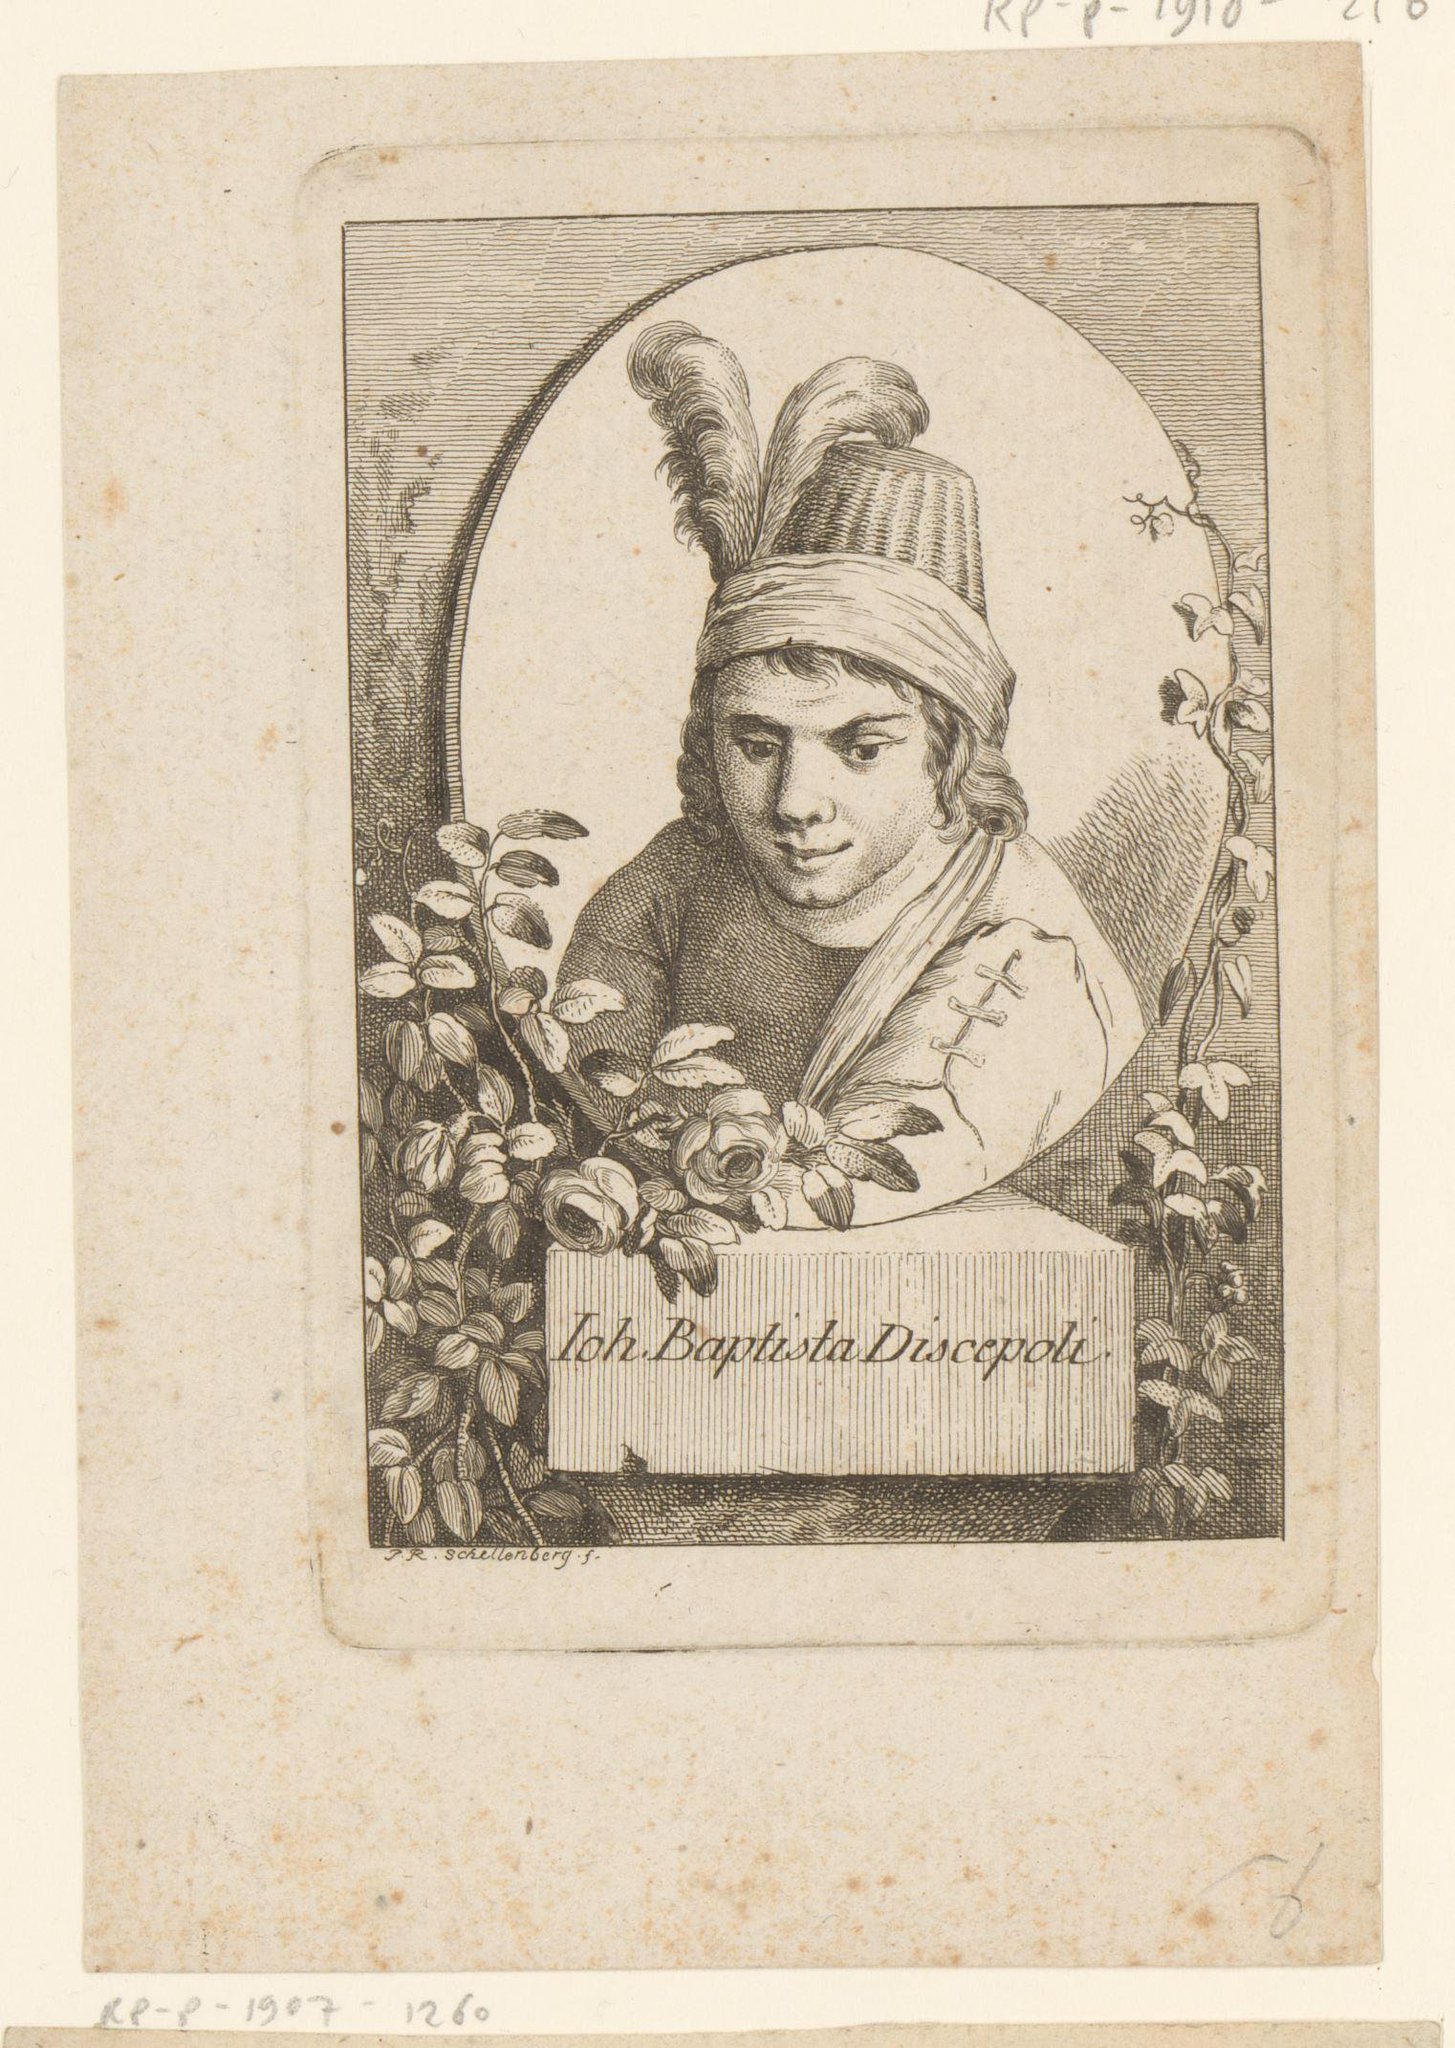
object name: print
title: Portret van Giovanni Battista Discepoli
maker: johann rudolph schellenberg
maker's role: print maker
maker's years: 1740-1806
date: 1750-1806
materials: paper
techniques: etching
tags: painter, portrait, self-portrait of artist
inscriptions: collector's mark: Lugt 2228